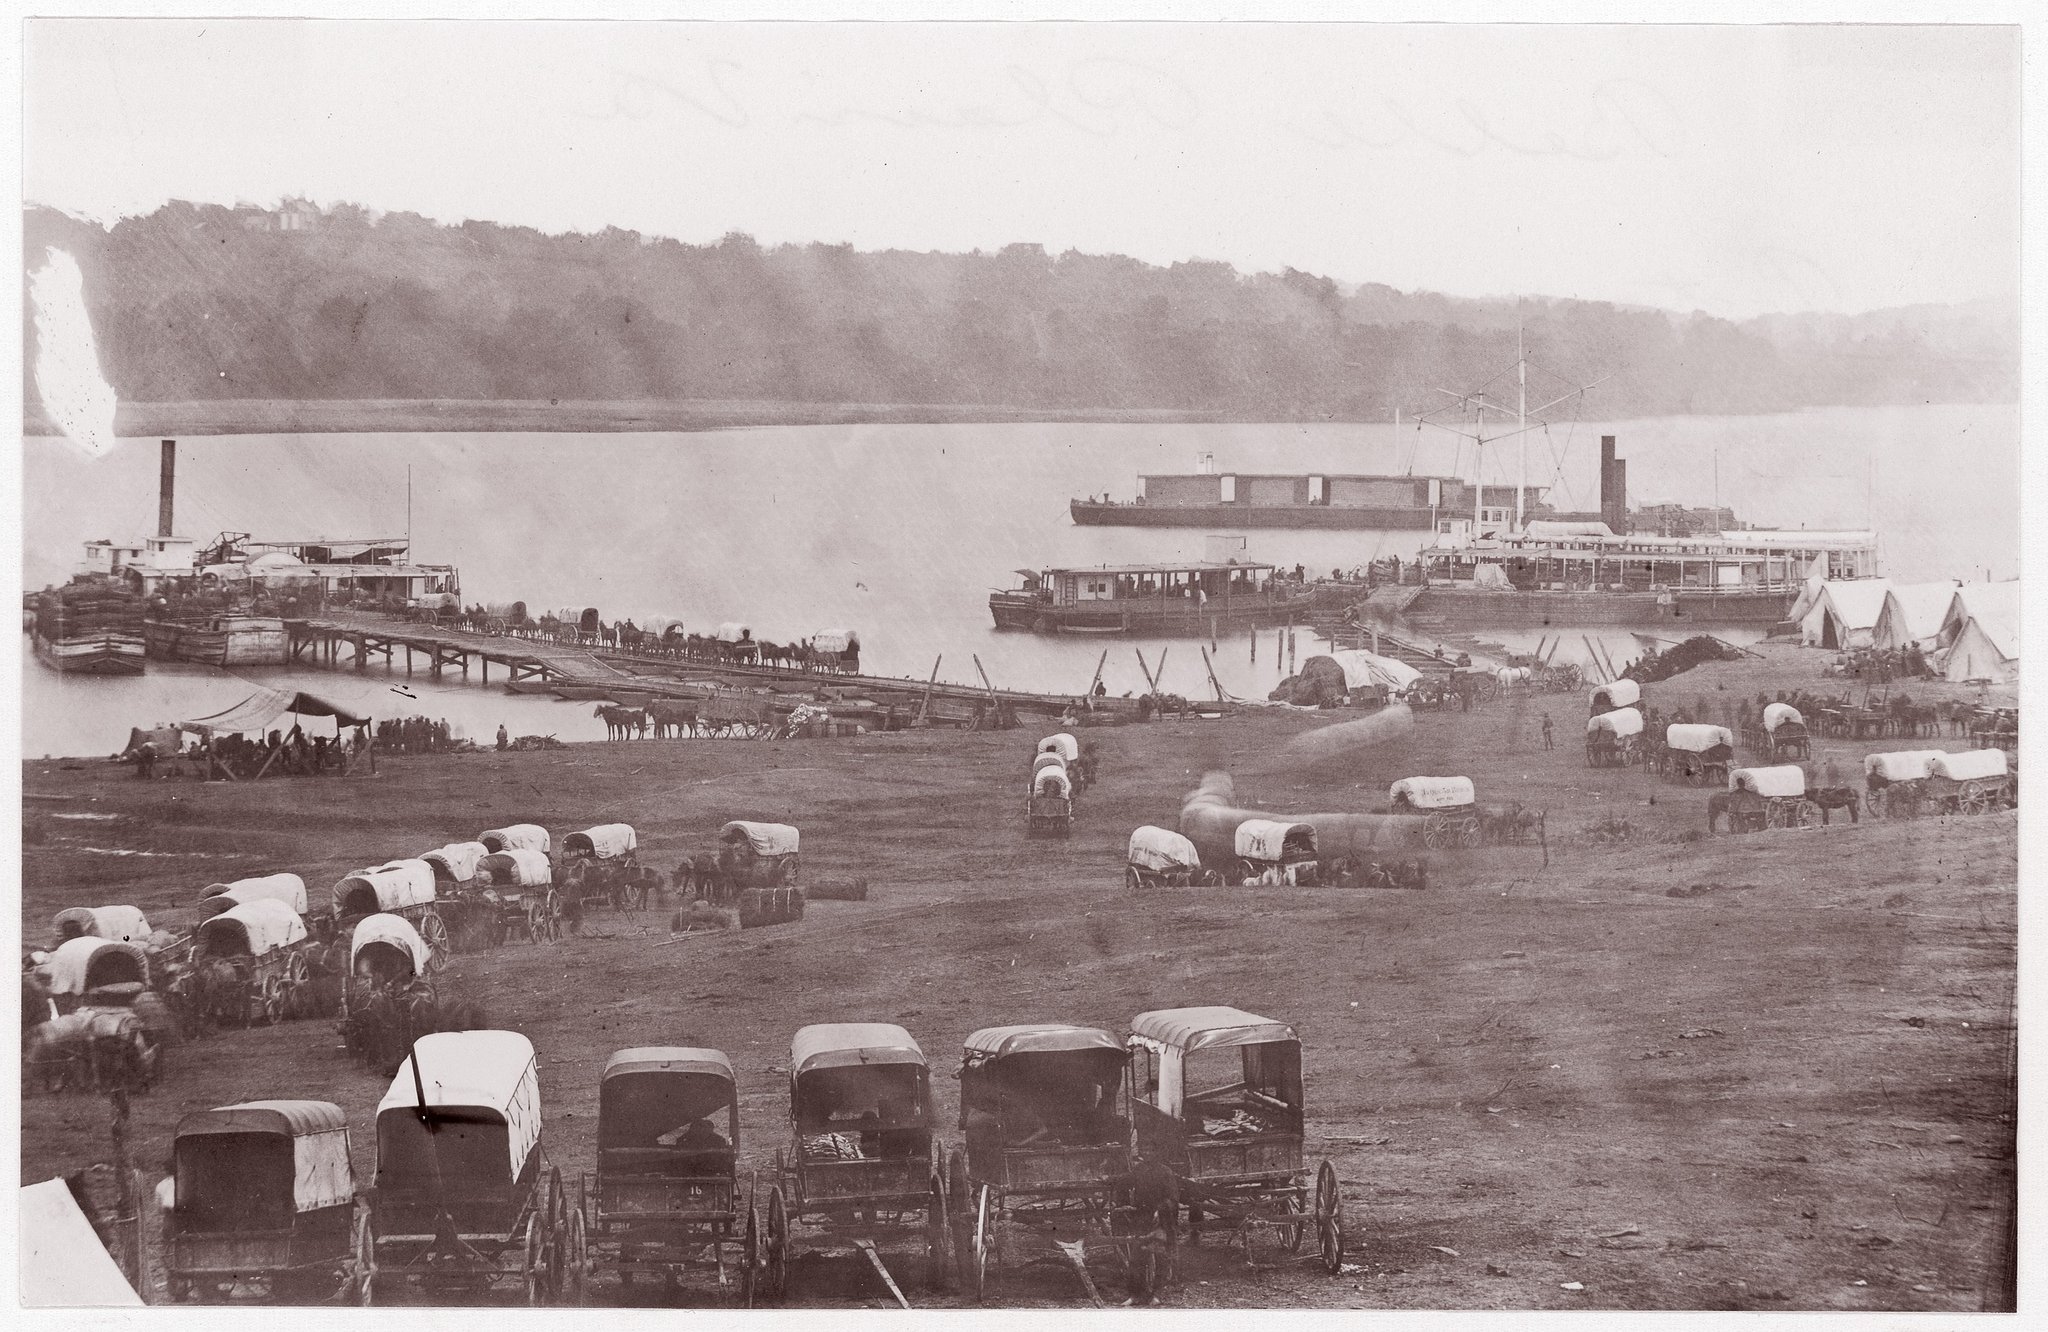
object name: photograph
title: [Upper Wharf with Wagon Park, Belle Plain, Virginia]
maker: james gardner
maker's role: artist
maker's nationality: american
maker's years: 1832-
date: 1864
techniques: albumen silver print, glass negative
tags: american civil war,rivers,carriages,ships